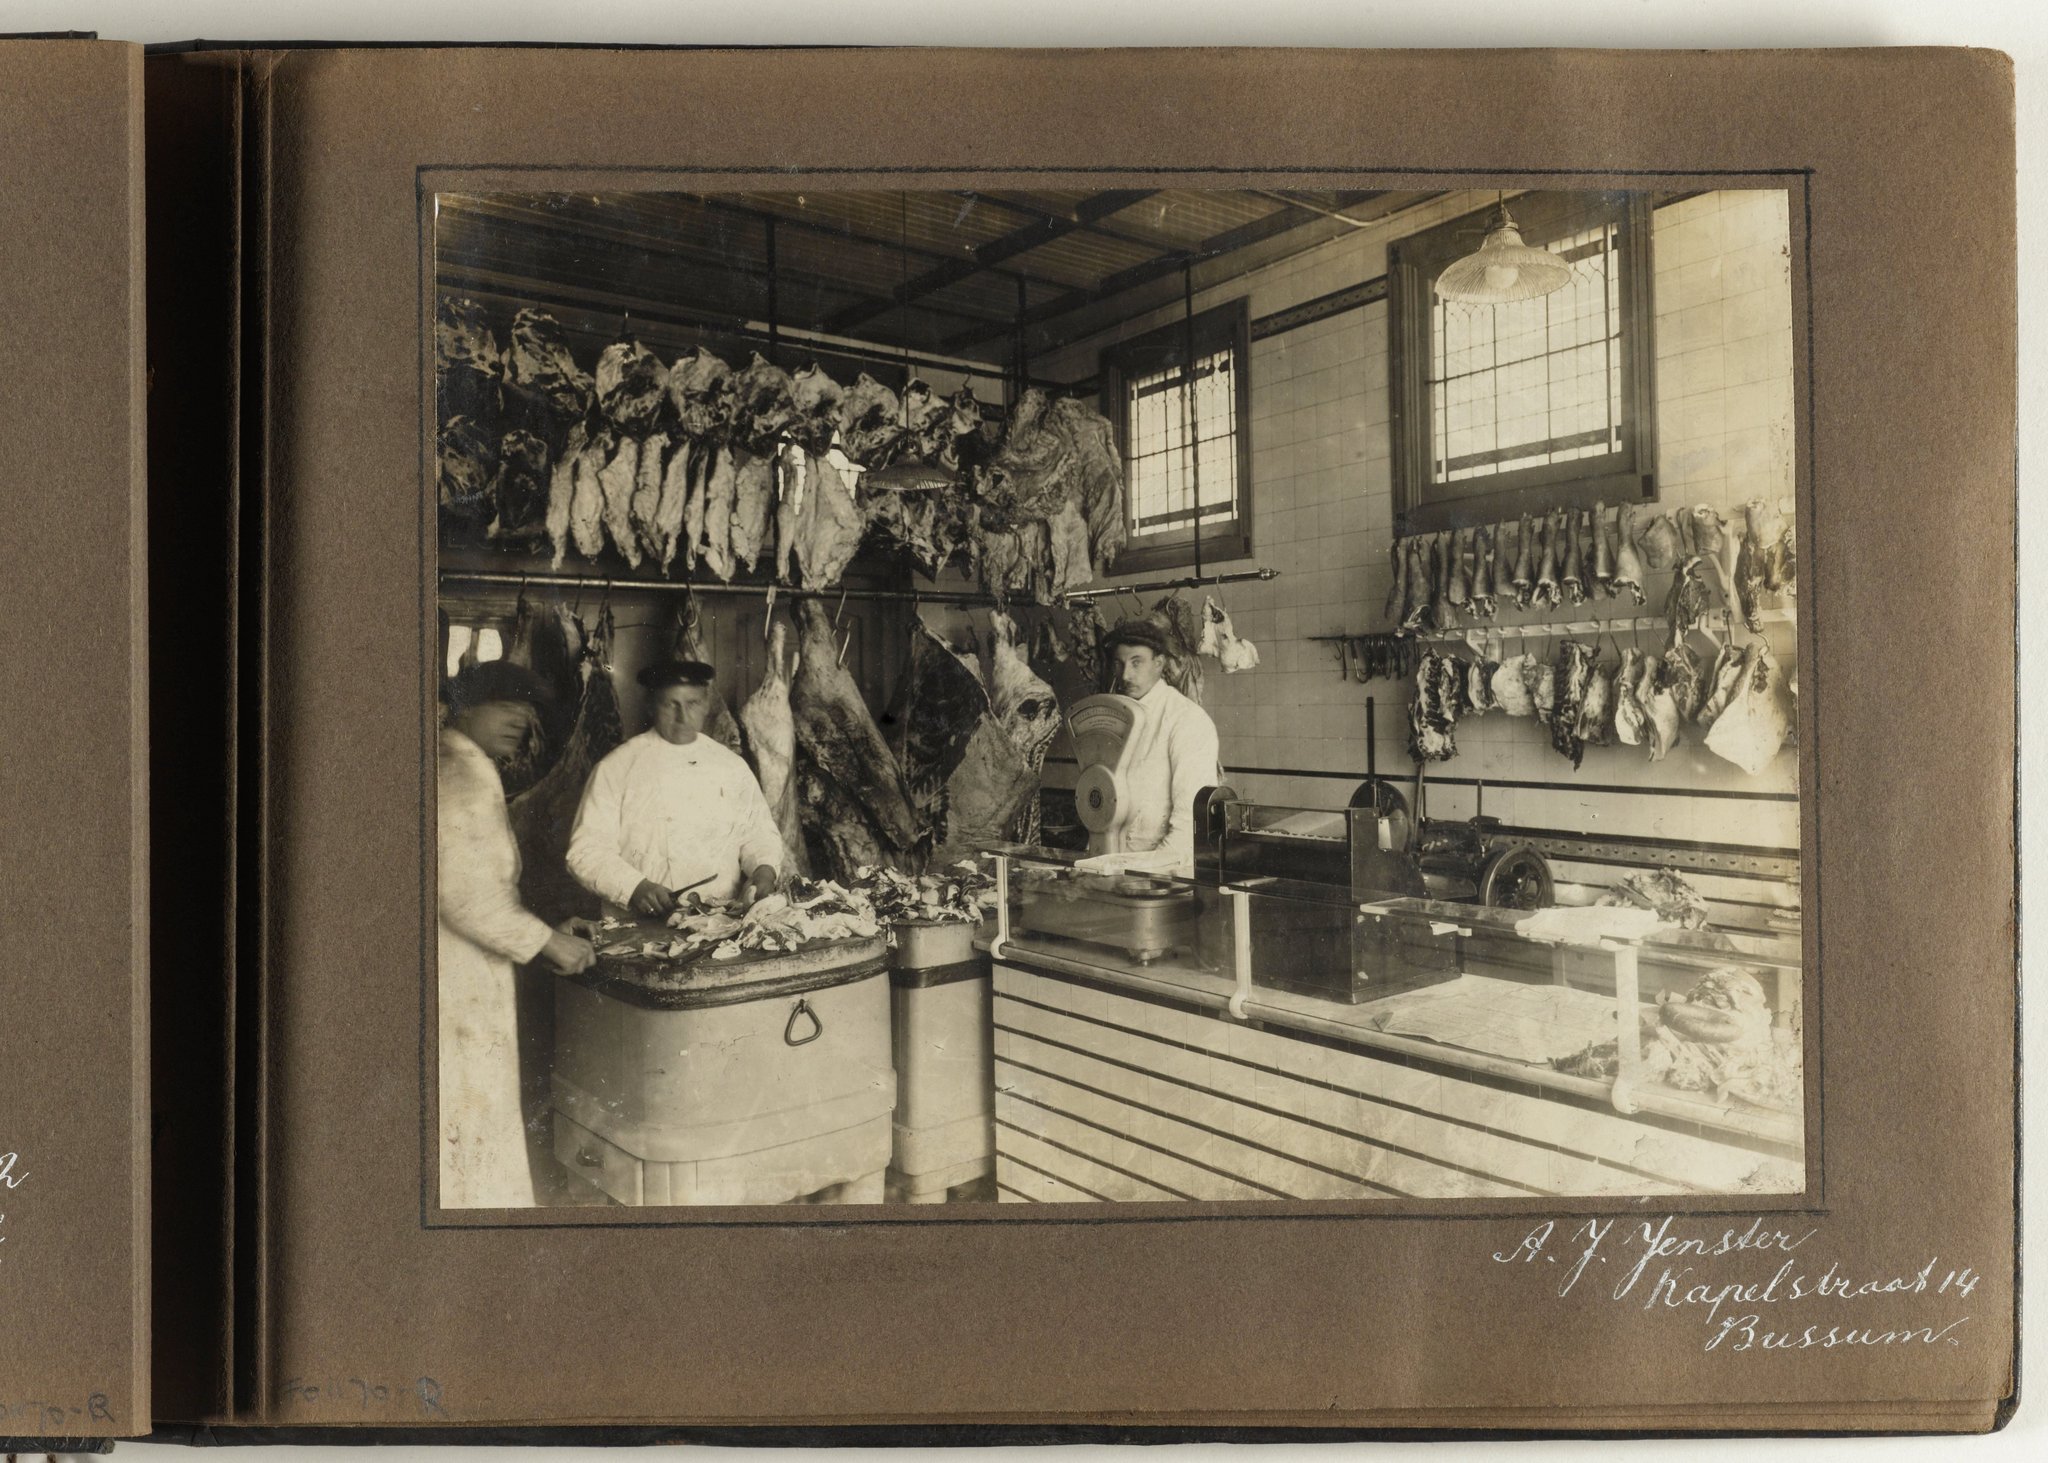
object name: album leaf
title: Interieur van de slagerij van A.J. Jenster, Kapelstraat 14, Bussum, Nederland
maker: Anonymous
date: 1925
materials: paper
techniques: gelatin silver print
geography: bussum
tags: counter ~ shop, butcher, slaughterman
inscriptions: annotation: ‘A.J. Jenster/ Kapelstraat 14/ Bussum’